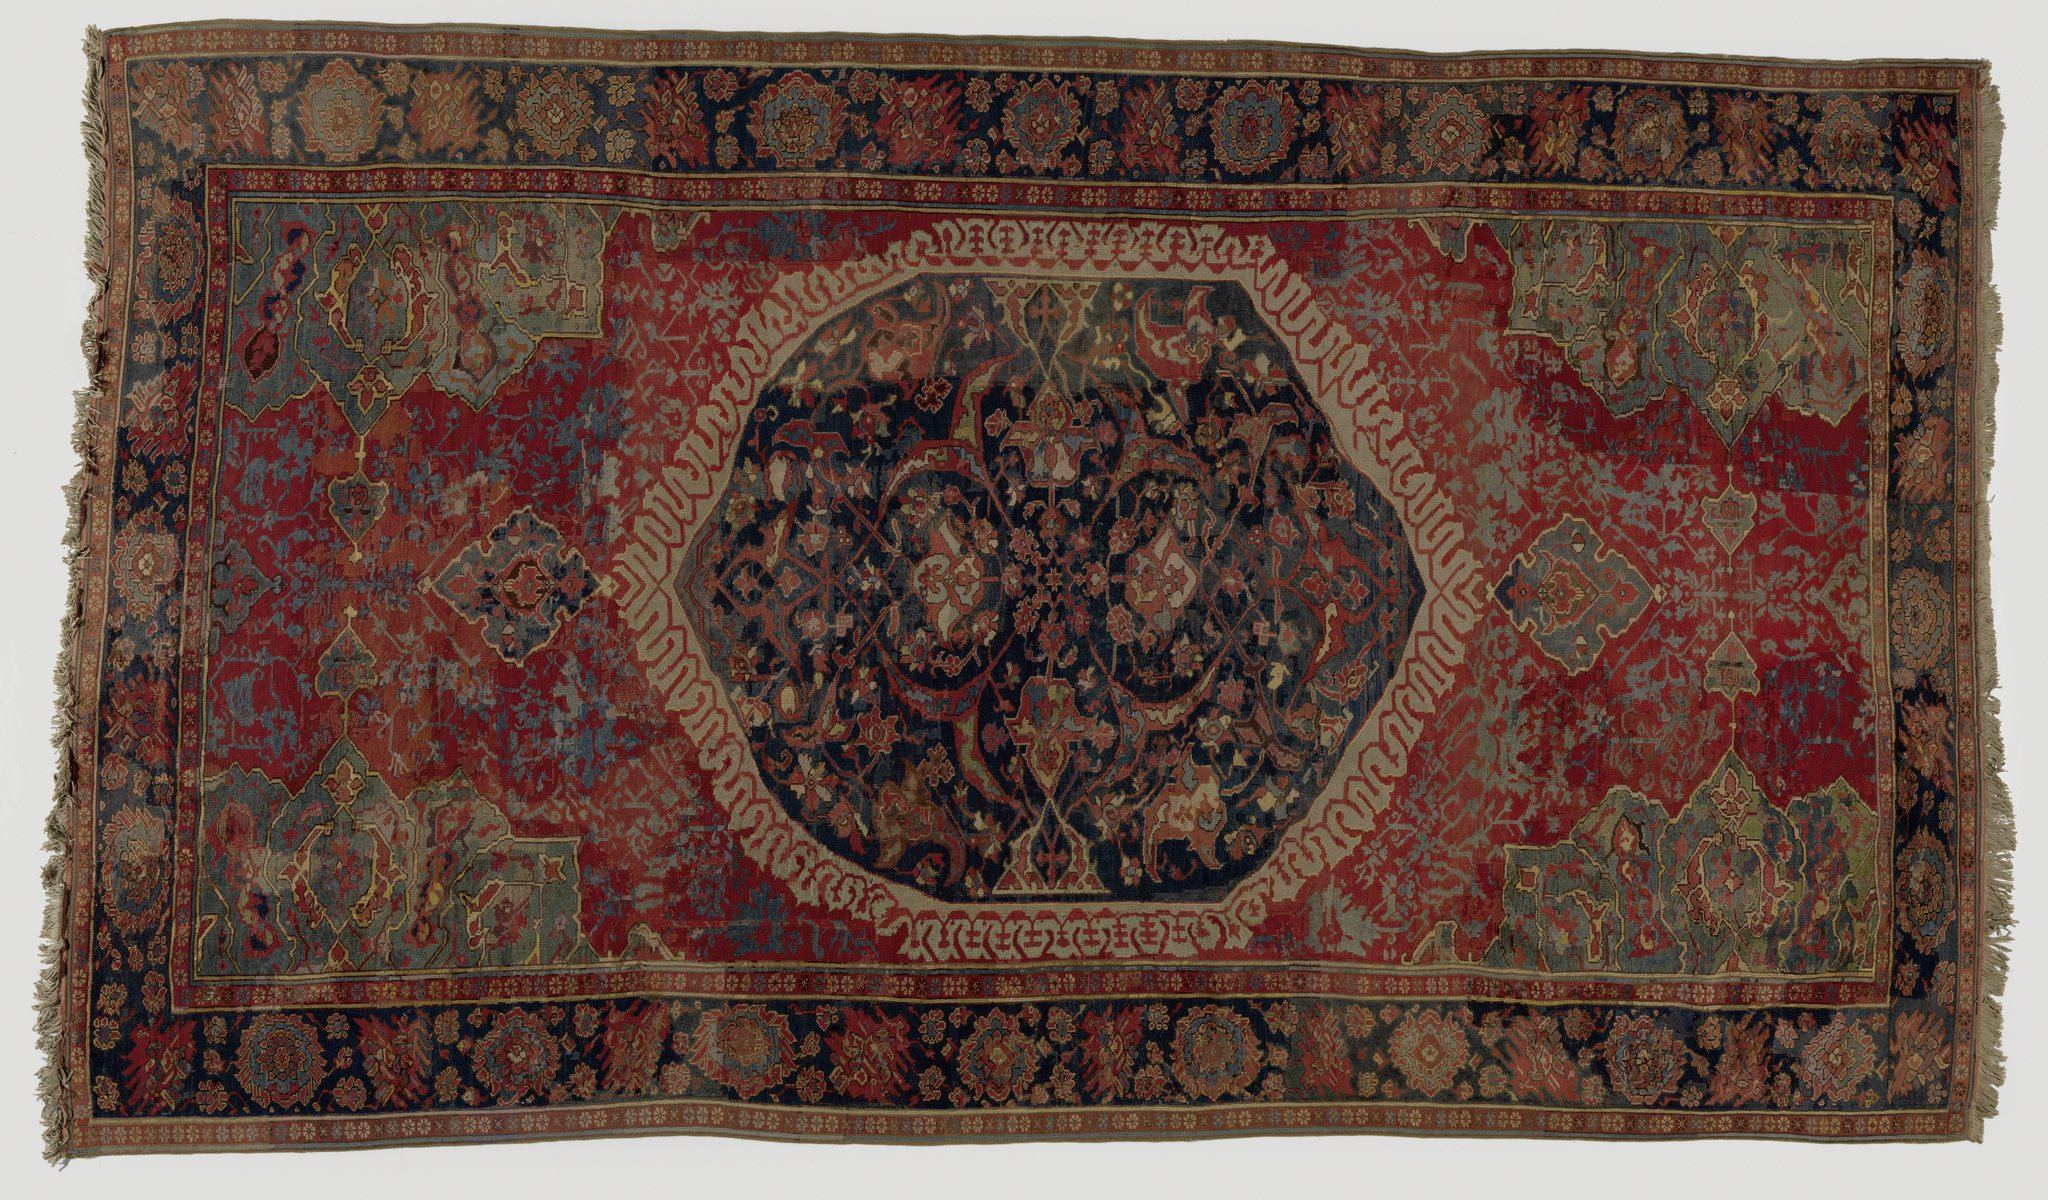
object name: medaillonkleed, medaillontapijt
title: Medaillonkleed, z.g. MEDAILLONUSHAK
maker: Anonymous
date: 1600-1699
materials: wool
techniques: ghiordes knot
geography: ushak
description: Medaillonkleed, z.g. MEDAILLONUSHAK. Middenveld: kersrode fond, waarop een saffierblauw zeszijdig medaillon met brede geslingerde omtrek in licht turkoisgroen. In het hart een fijne rode achtzijdige ster met vier uitstralende symmetrische palmetten met lichtblauwe, witte en gele motieven en vier lichtrode arabeskbladeren aan ranke stengels. Daaromheen groeien bovendien twee donkerder rode en twee gele arabesken en twee paar grote kelkbloemen. Aan top en voet van het medaillon telkens een blauwe palmet. In de hoeken stermedailons - iets hoger dan een kwart ster - in flessengroen met geel omrande rode arabesken en palmetten. Veldvulling met effen kobaltblauwe vertakte grillige bladranken. Rand: saffierblauwe rand met palmetbloemen in rood, lichtblauw en geel, afgewisseld door bladeren in rood, waarop bloemetjes in losse rozetjes in blauw, geel, groen en bruin.